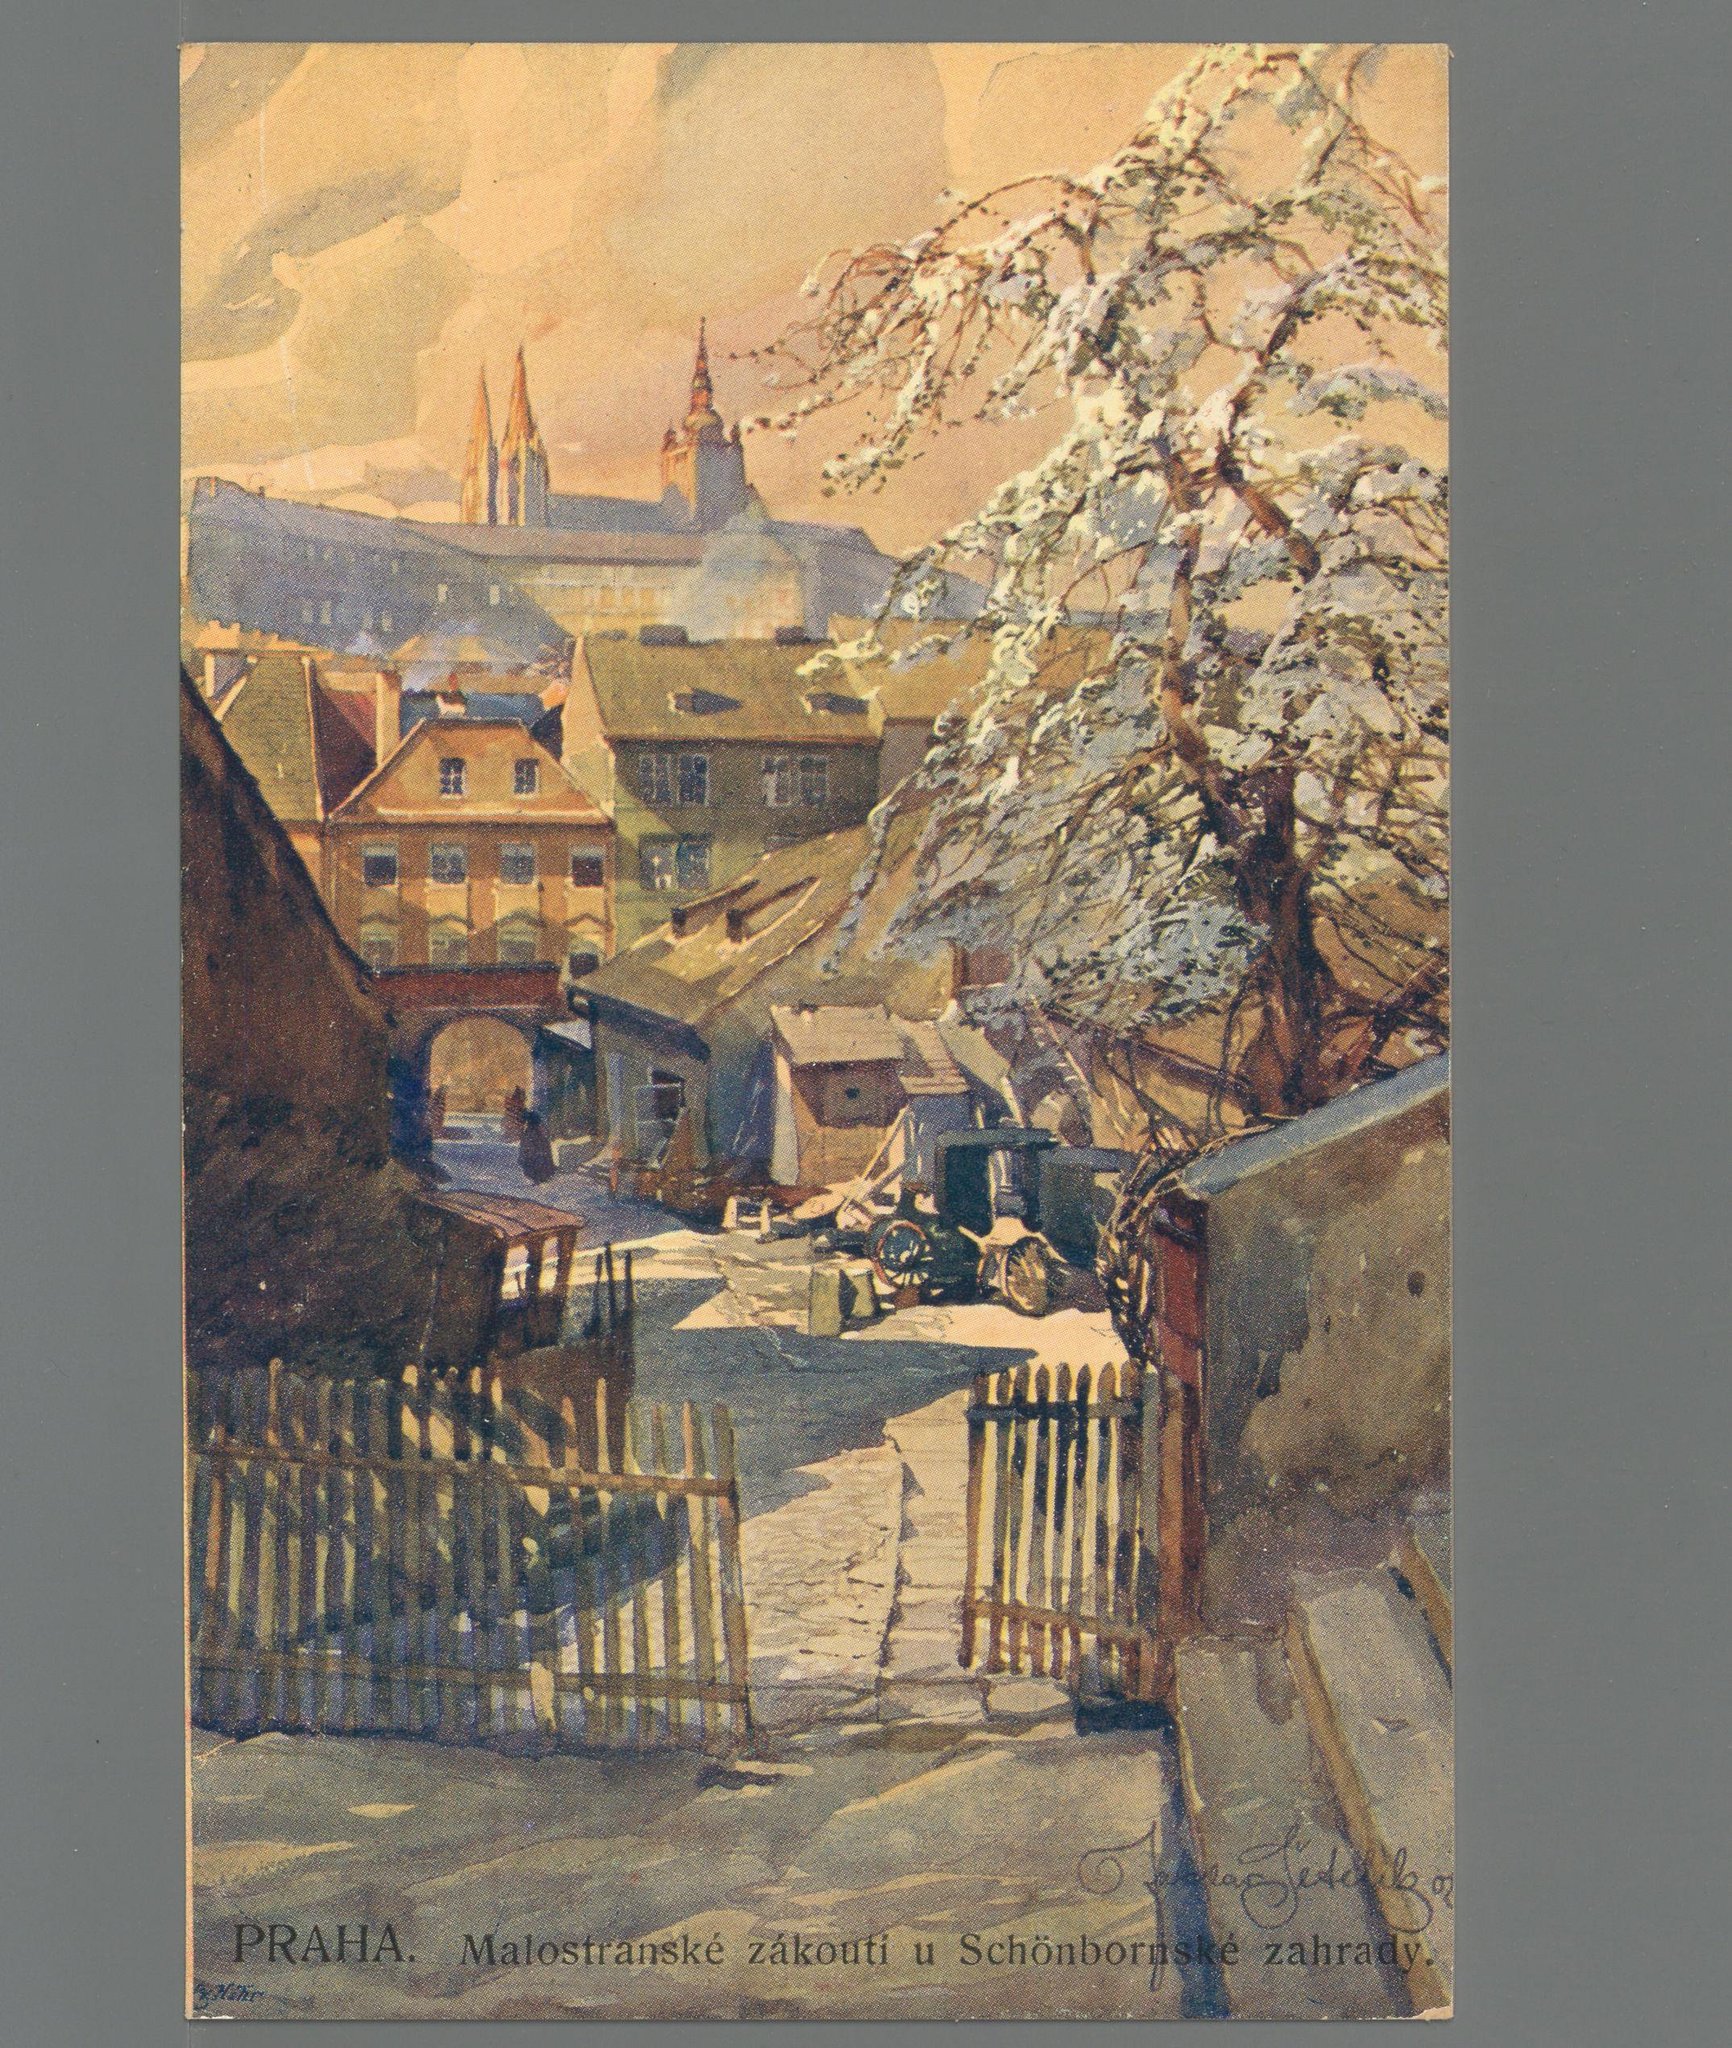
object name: photomechanical print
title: Praha. Malostranské zákouti u Schönbornské zahrady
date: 1906-1930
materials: cardboard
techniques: color autotype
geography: prague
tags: castle, church (exterior), street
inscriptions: inscription: ‘H&H’